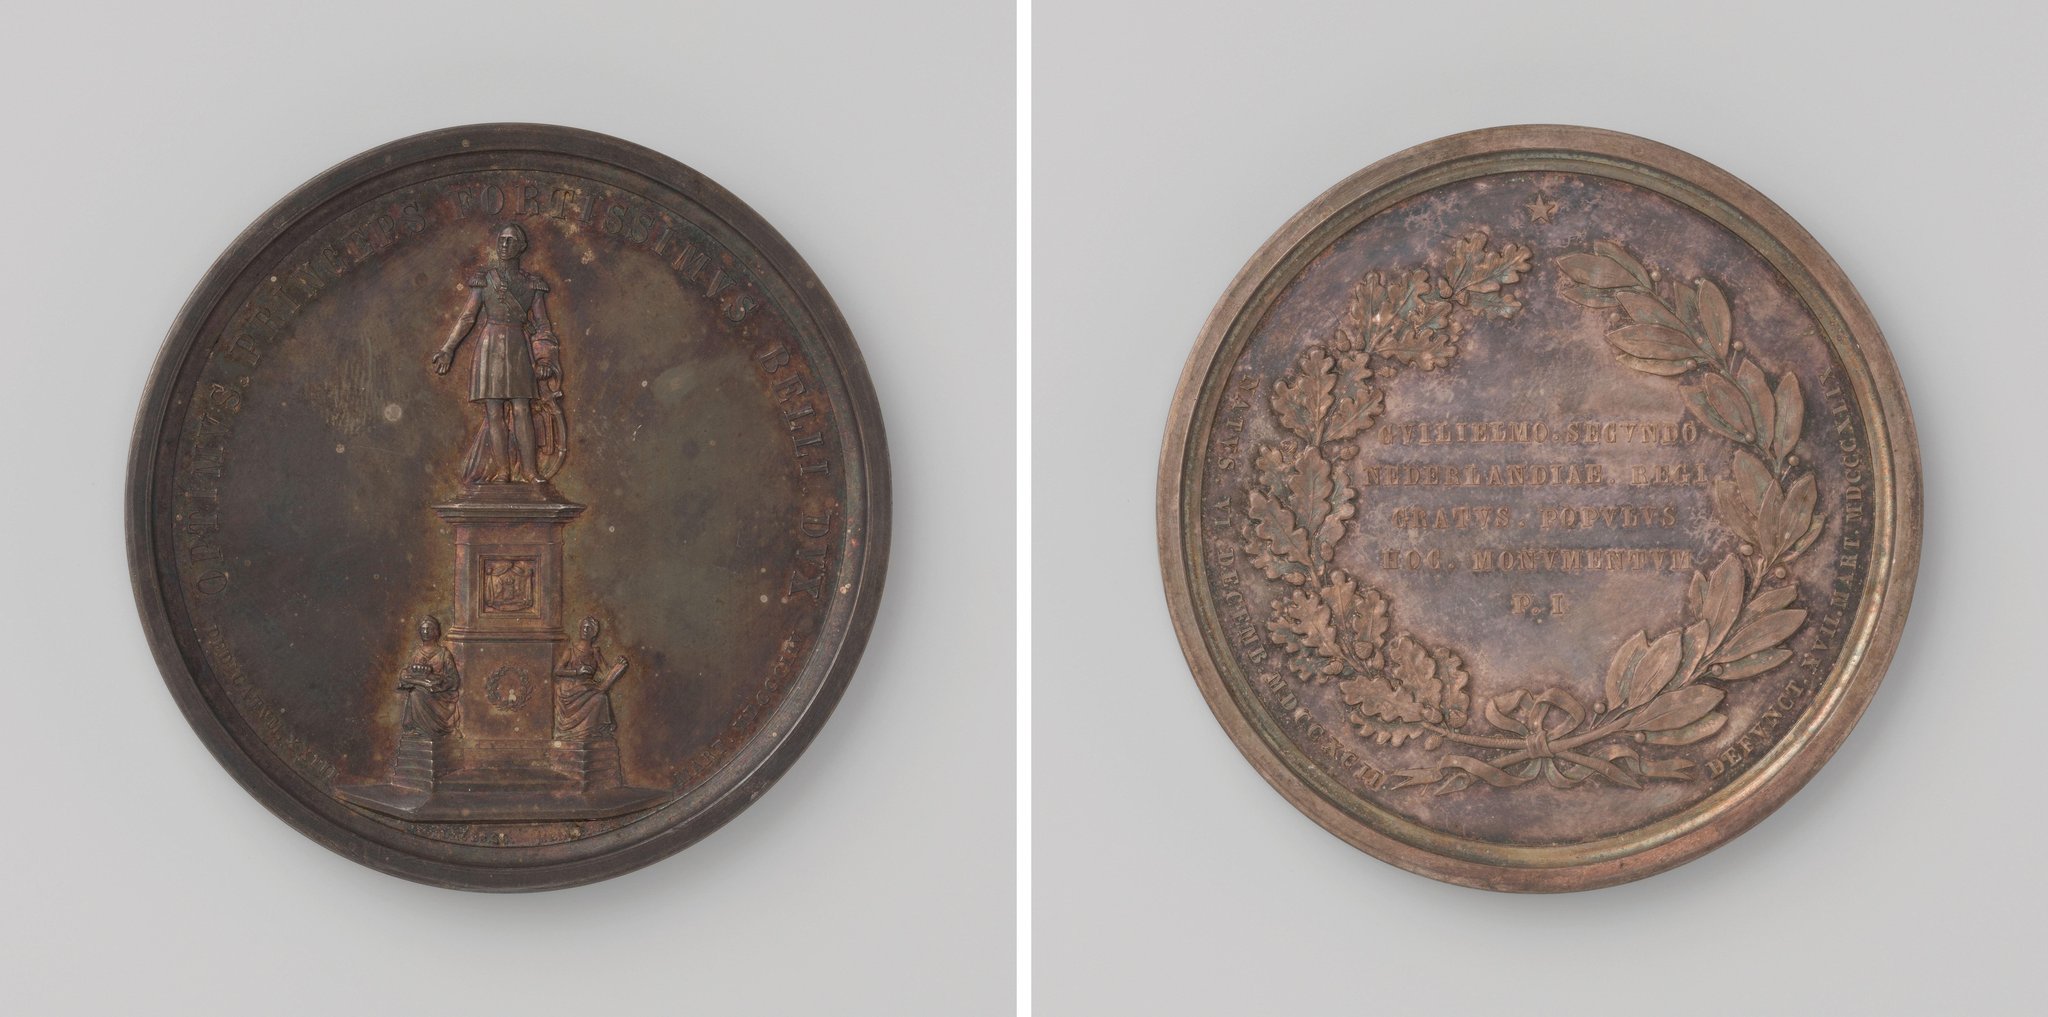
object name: history medal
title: Oprichting van een standbeeld te 's-Gravenhage voor Willem II, koning der Nederlanden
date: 1854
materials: silver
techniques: striking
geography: utrecht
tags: the hague, william ii of the netherlands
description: Zilveren penning. Voorzijde: standbeeld op sokkel, geflankeerd door twee beelden binnen omschrift. Keerzijde: opschrift binnen tot krans samengebonden eike- en lauwertak binnen omschrift